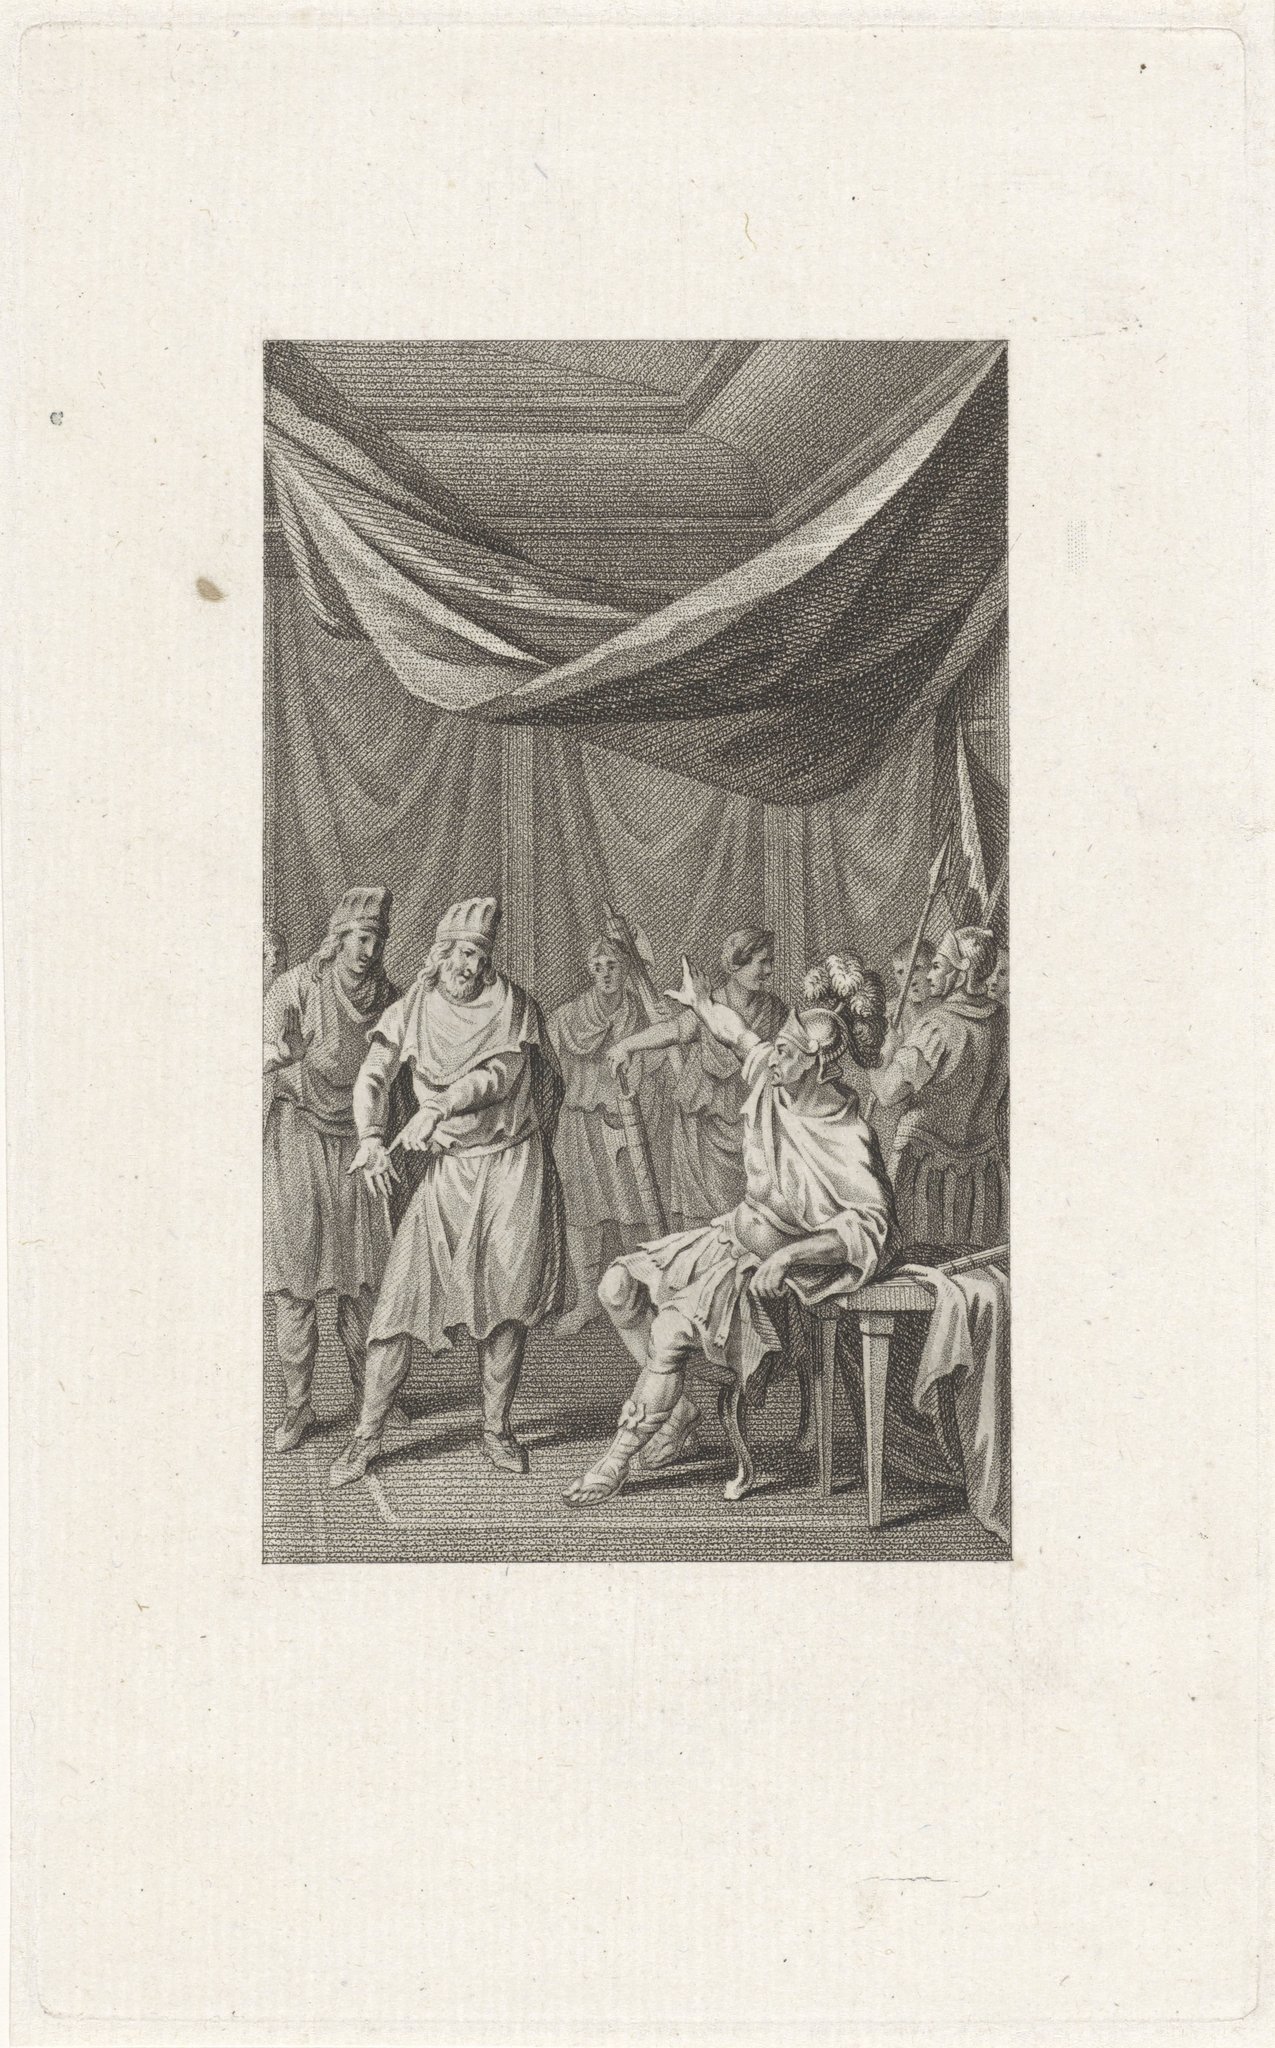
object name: print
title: Marcus Licinius Crassus uitgelachen door Parthische afgezanten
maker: ludwig gottlieb portman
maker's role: print maker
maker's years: 1772-1828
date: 1800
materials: paper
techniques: etching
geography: amsterdam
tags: (story of) m. licinius crassus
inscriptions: collector's mark: Lugt 2228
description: De Parthische veldheer Vagises wijst op de binnenkant van zijn hand. Hij zegt tegen Marcus Licinius Crassus dat er nog sneller haar op zijn hand zal groeien dan dat Crassus Seleucia zal bereiken.